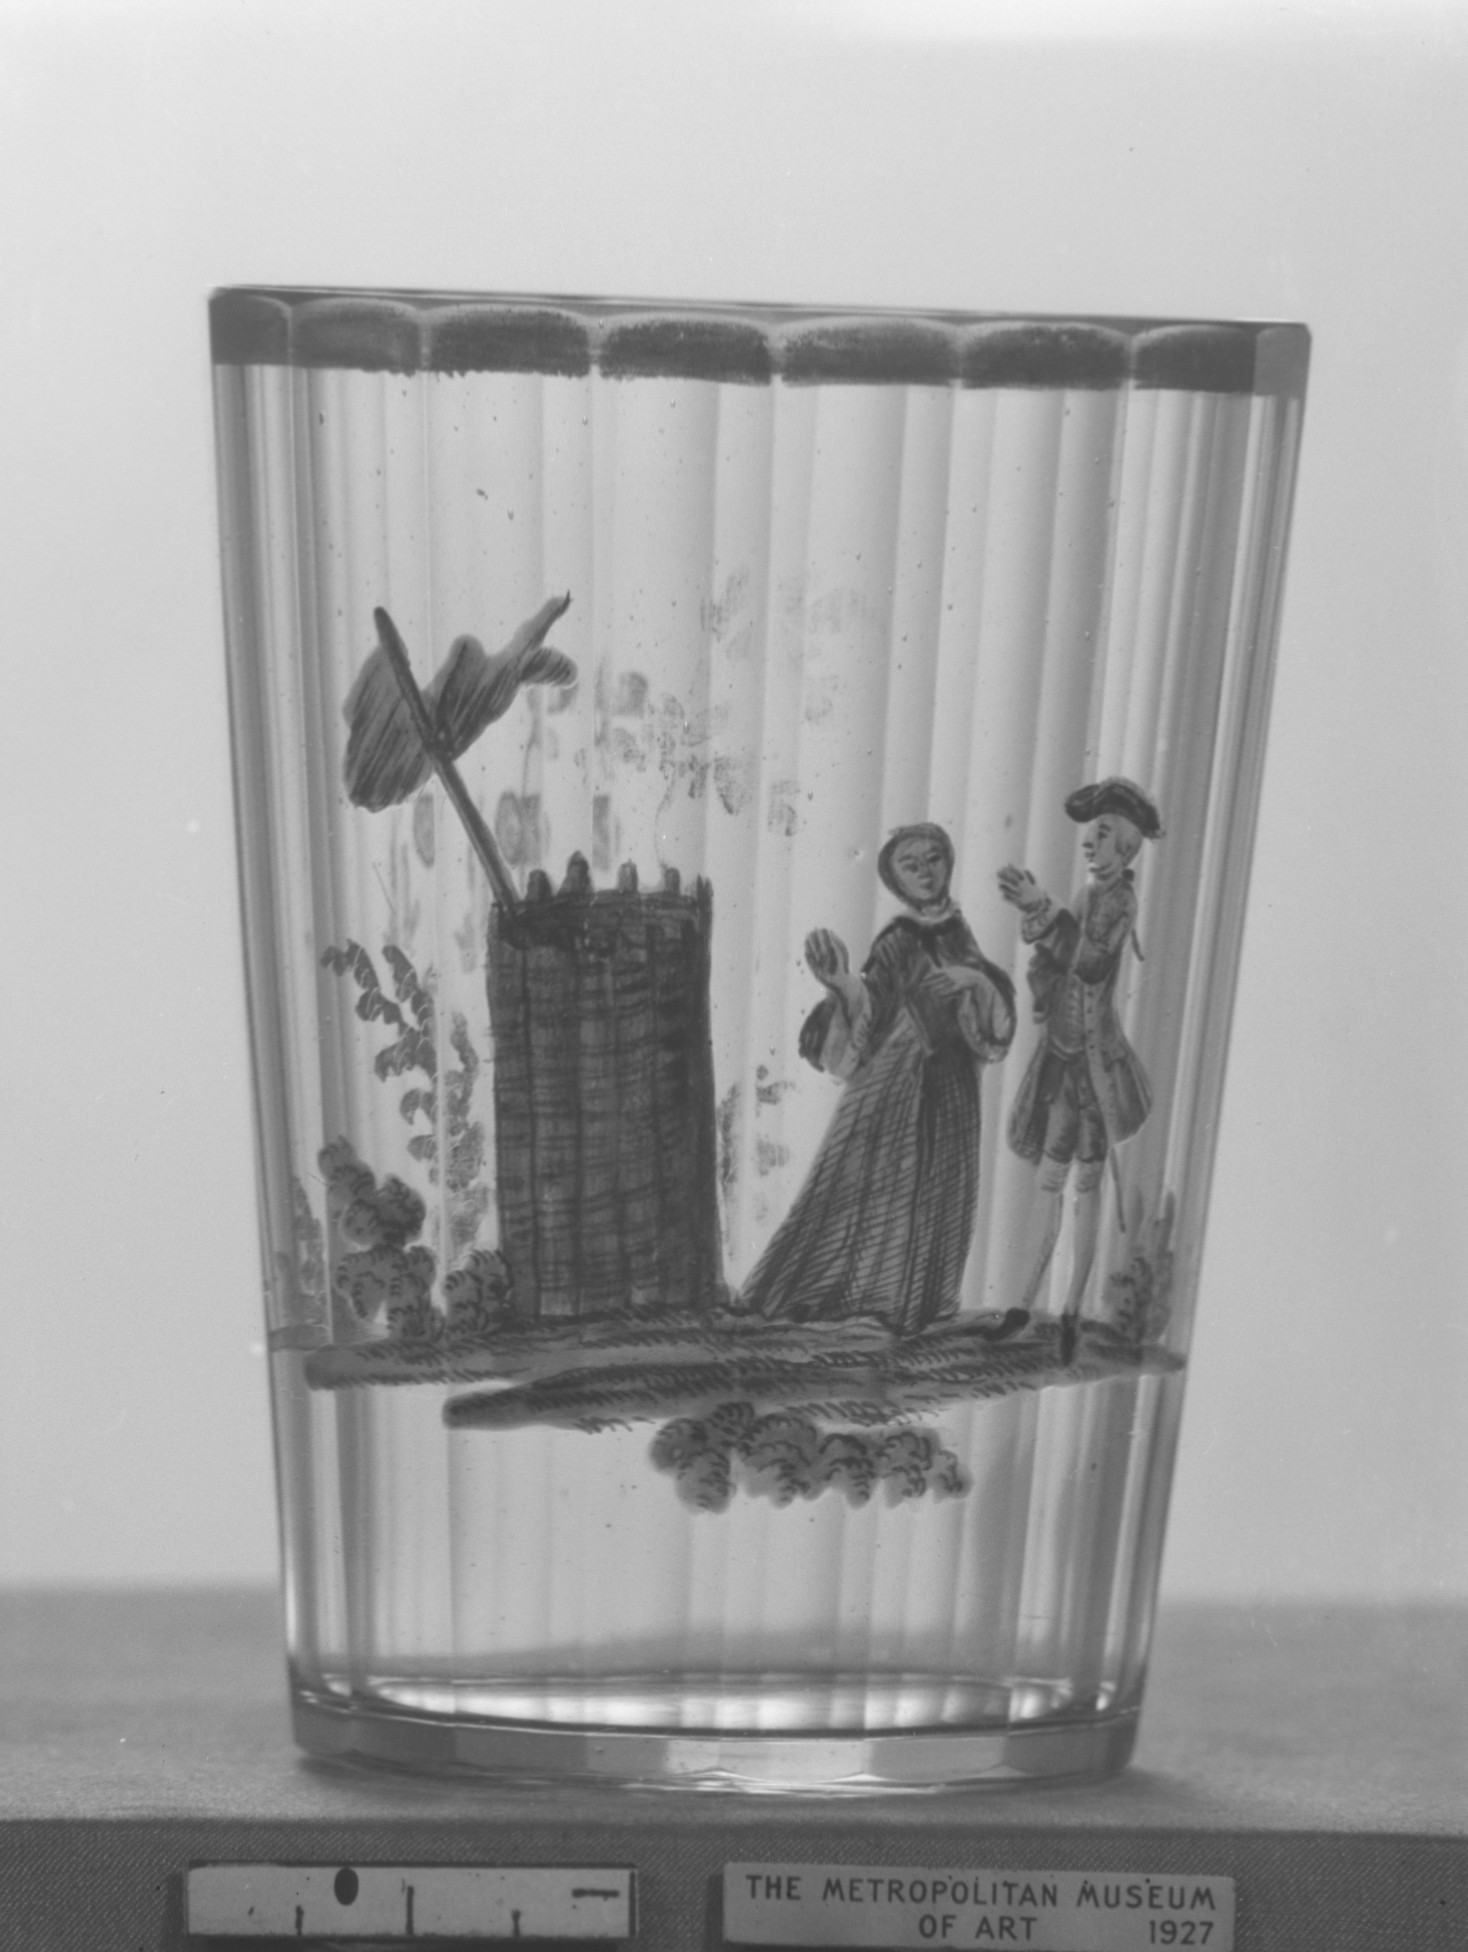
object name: beaker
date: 1770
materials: glass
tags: men,women